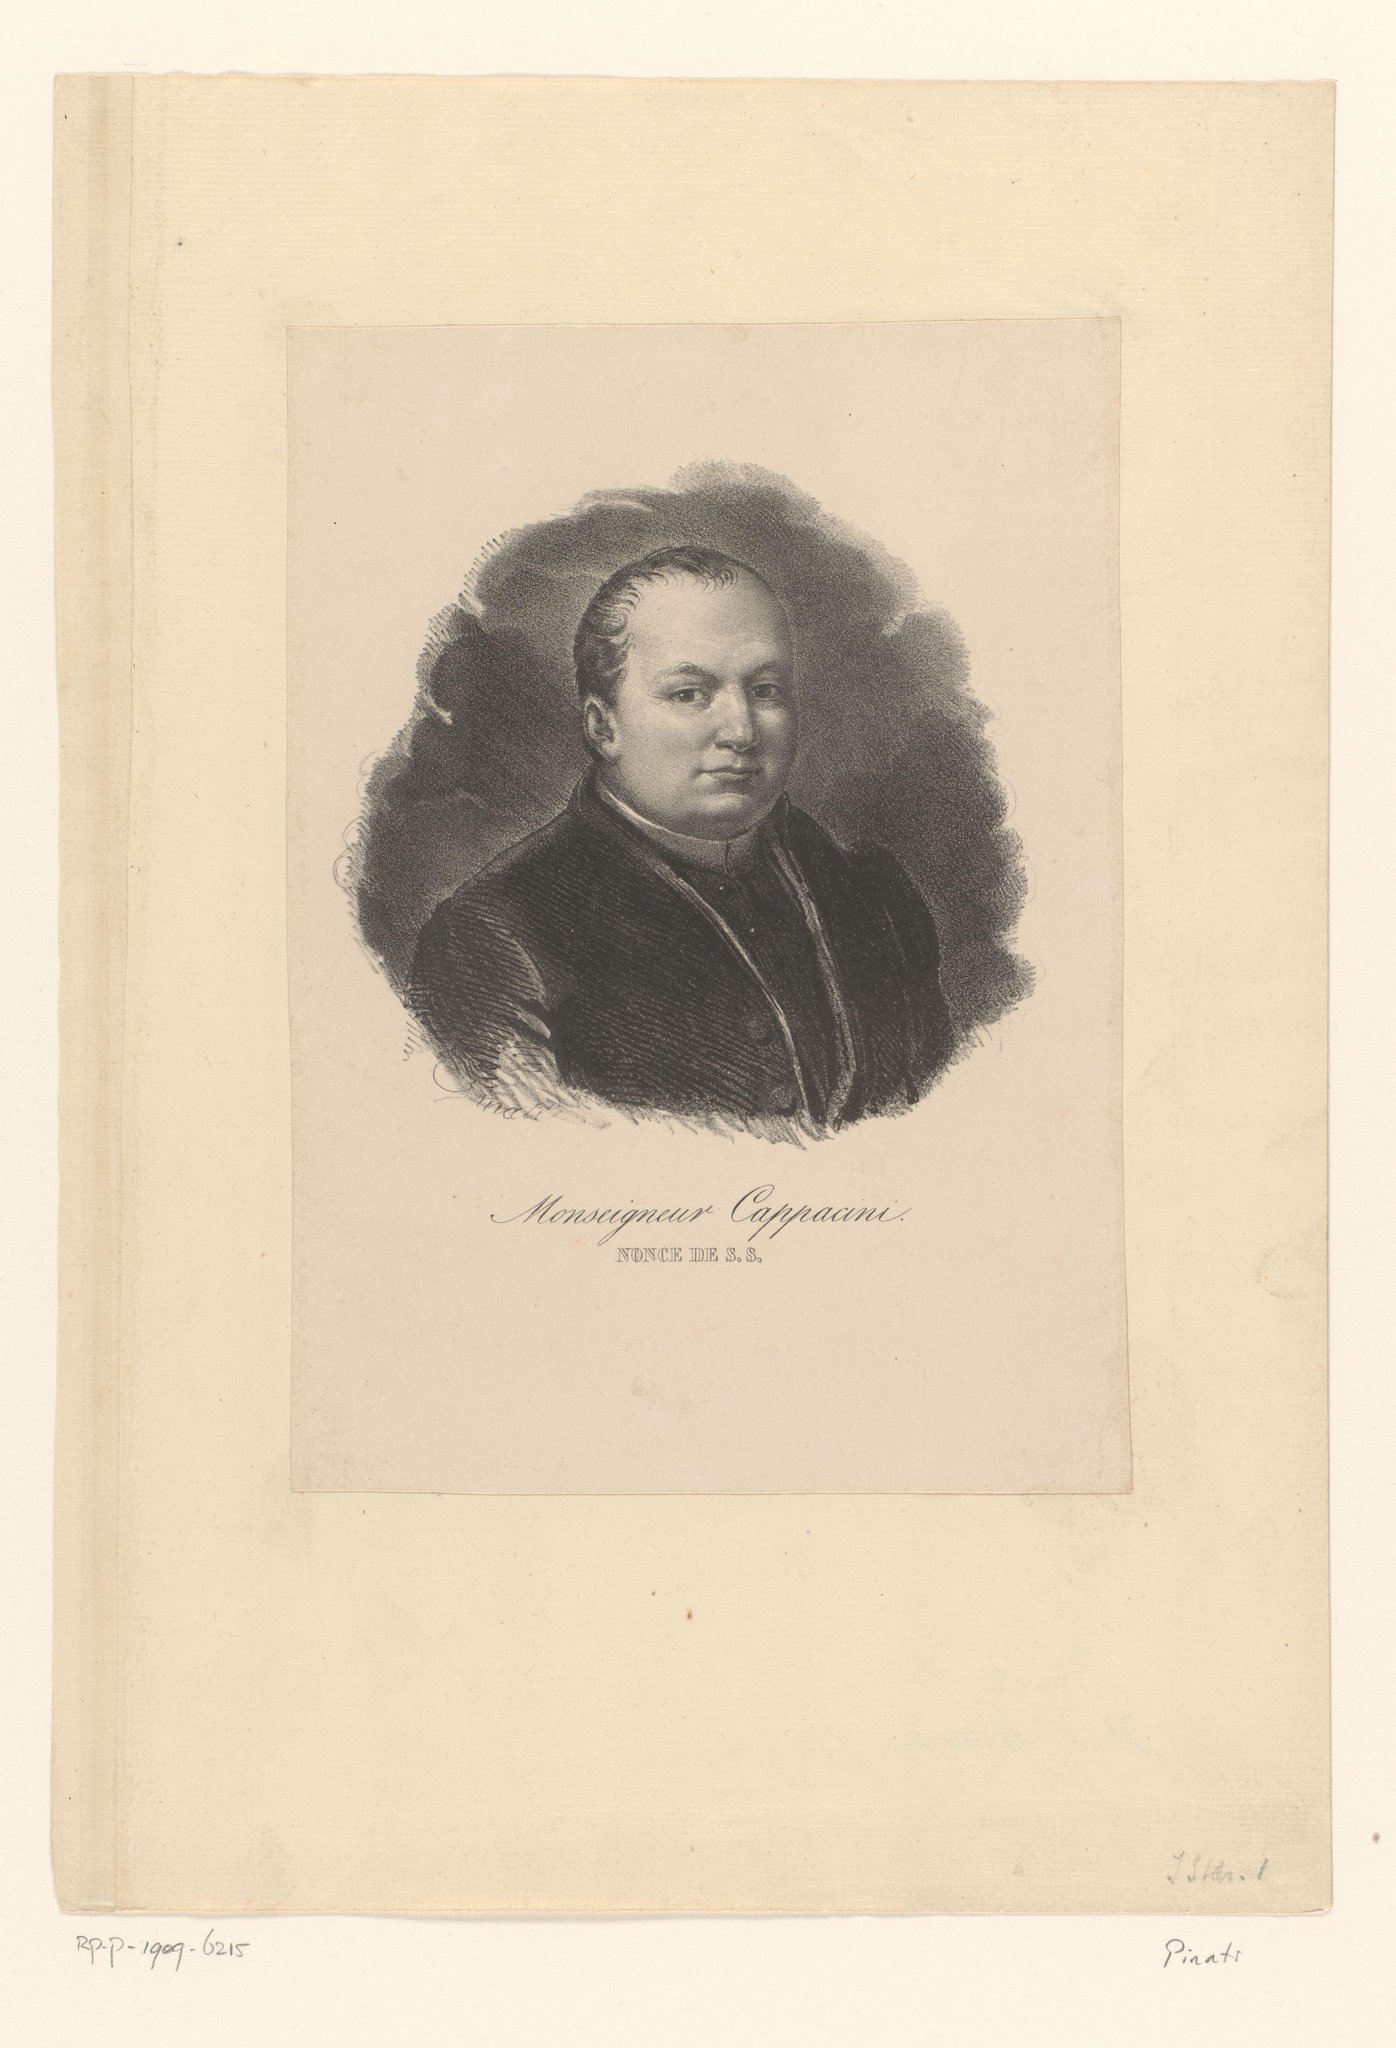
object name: print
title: Portret van de heer Cappacini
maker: pinati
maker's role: print maker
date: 1800-1899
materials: paper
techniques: lithograph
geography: italy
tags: historical persons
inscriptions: collector's mark: Lugt 2228